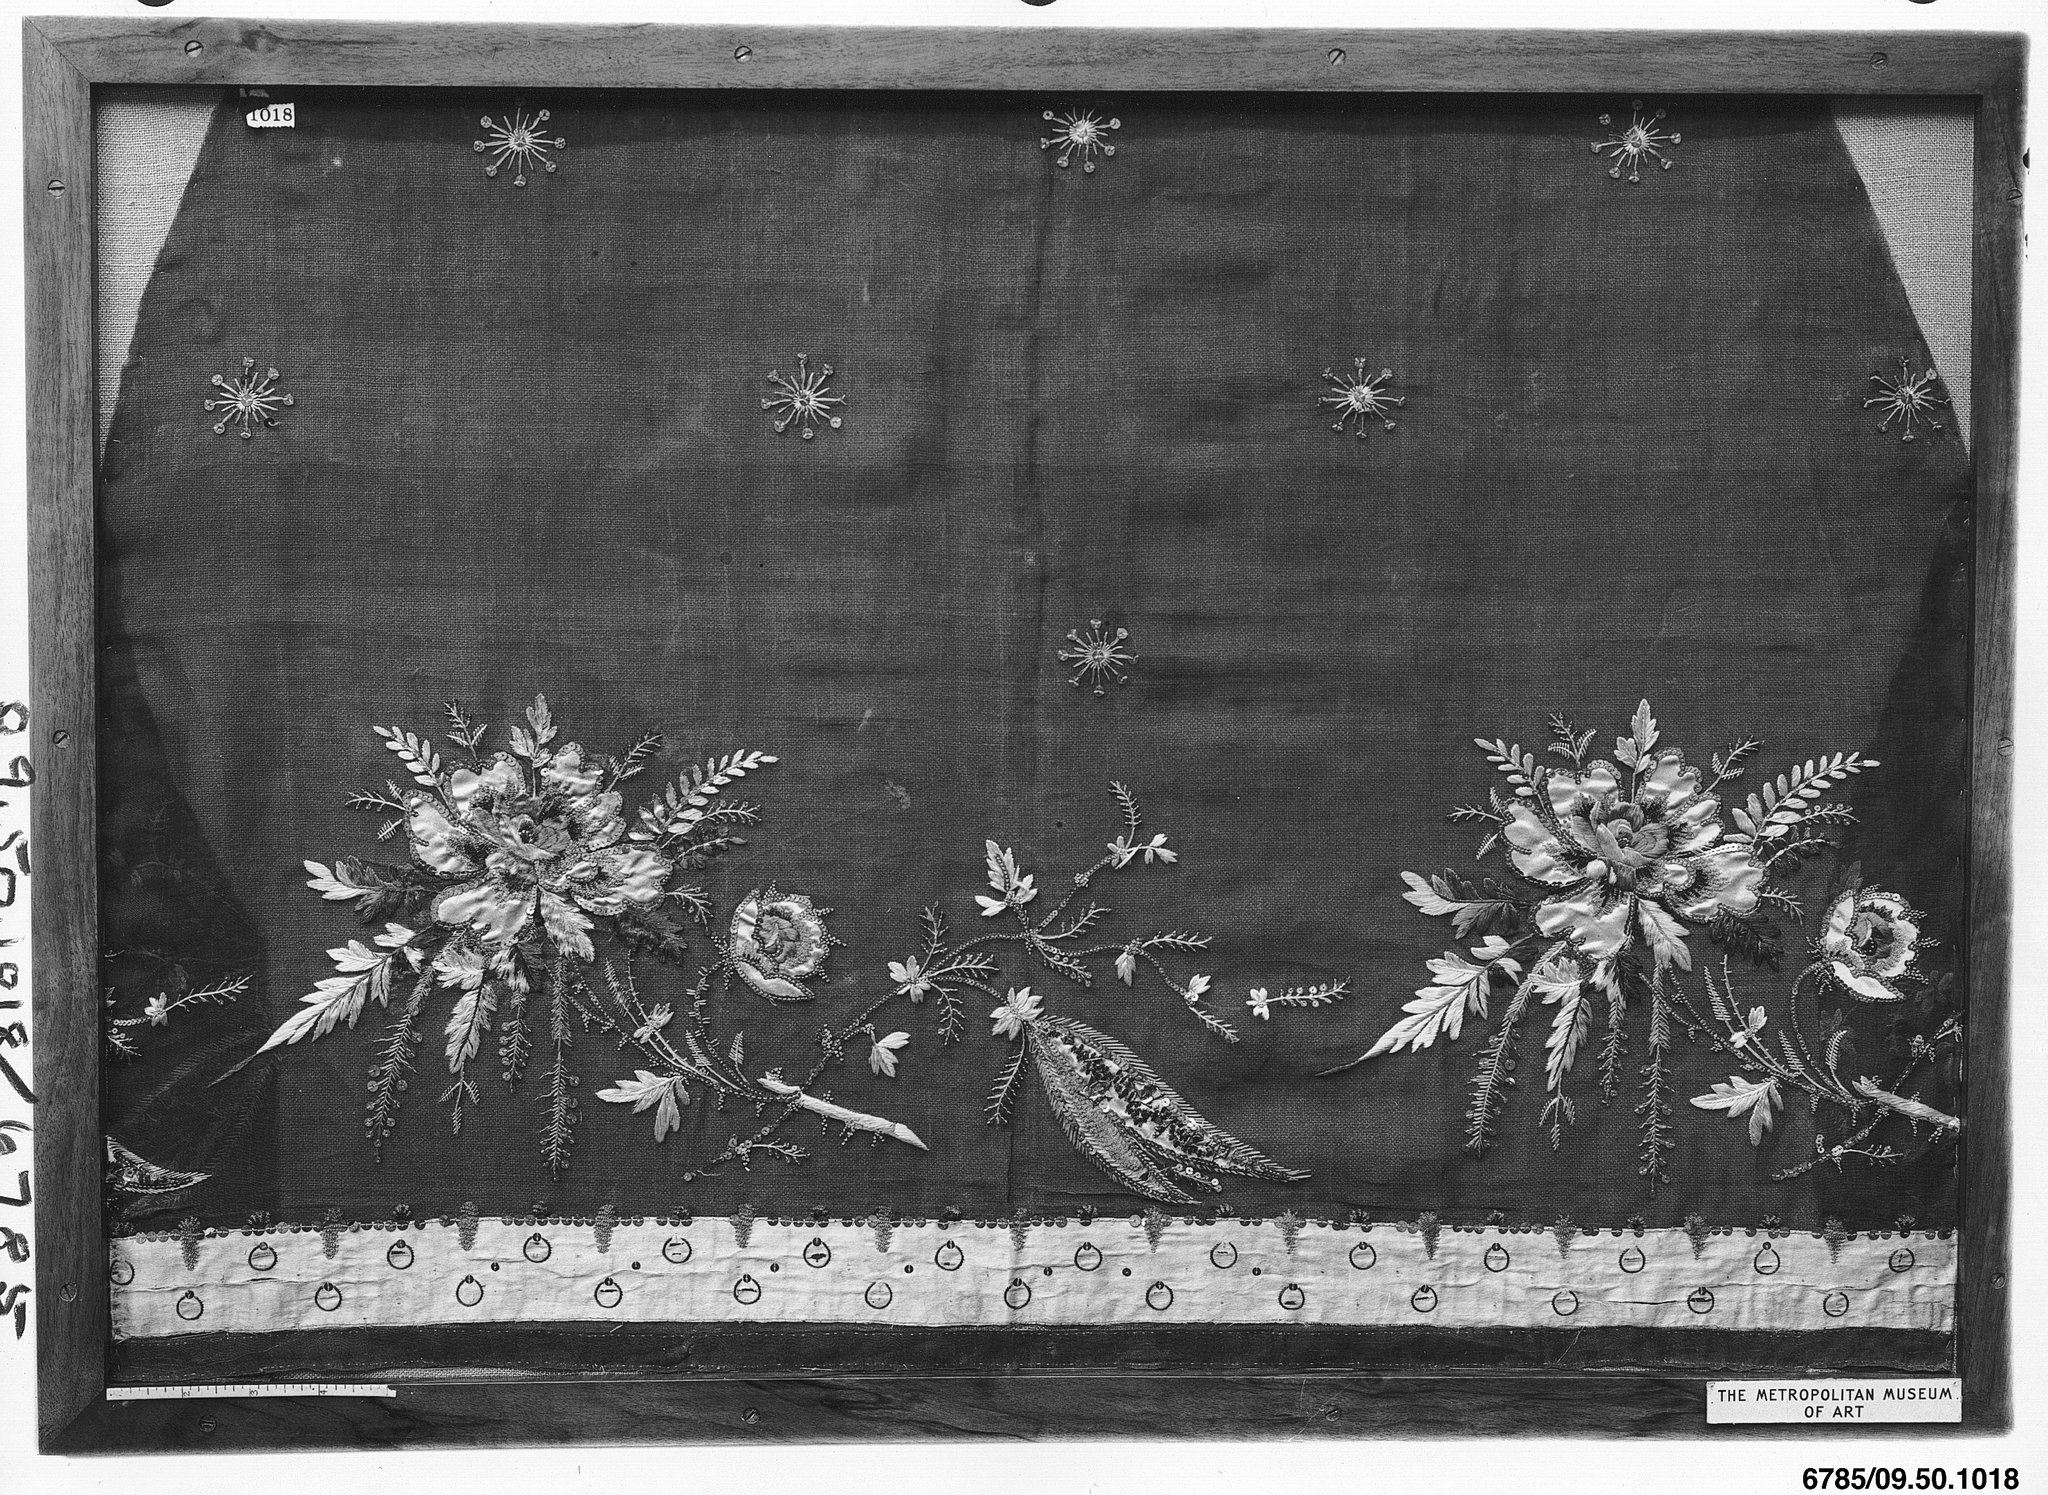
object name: border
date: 1801-1833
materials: silk